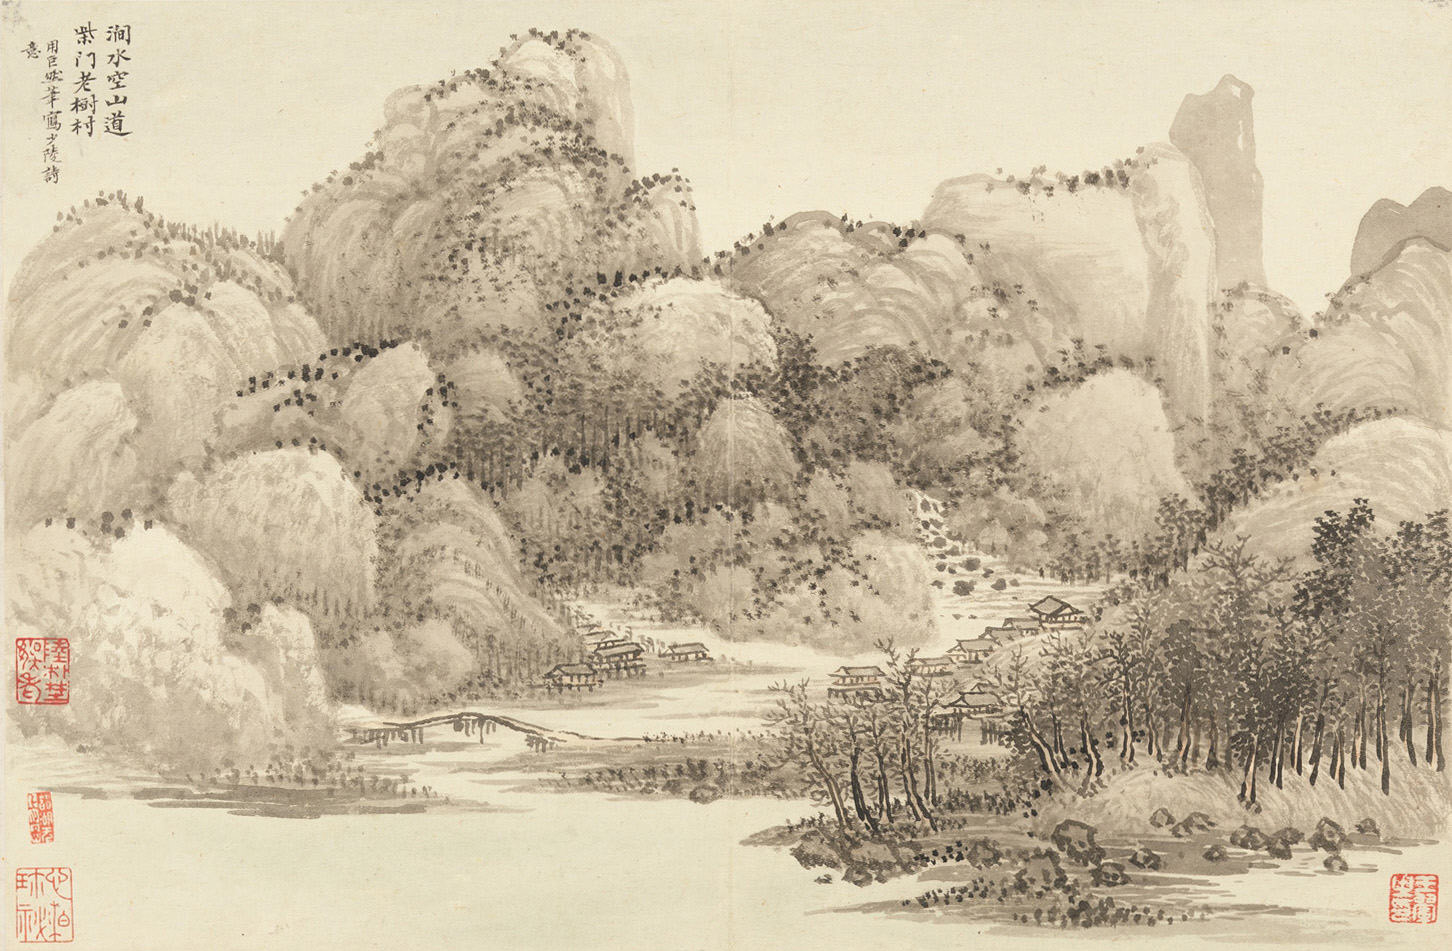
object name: album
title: Landscapes after old masters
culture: chinese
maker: wang hui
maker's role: artist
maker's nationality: chinese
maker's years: 1632-1717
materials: ink, paper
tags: mountains,landscapes